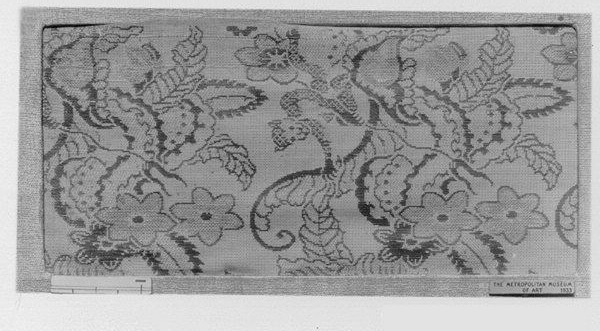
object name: piece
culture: japanese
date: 1701-1900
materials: silk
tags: leaves